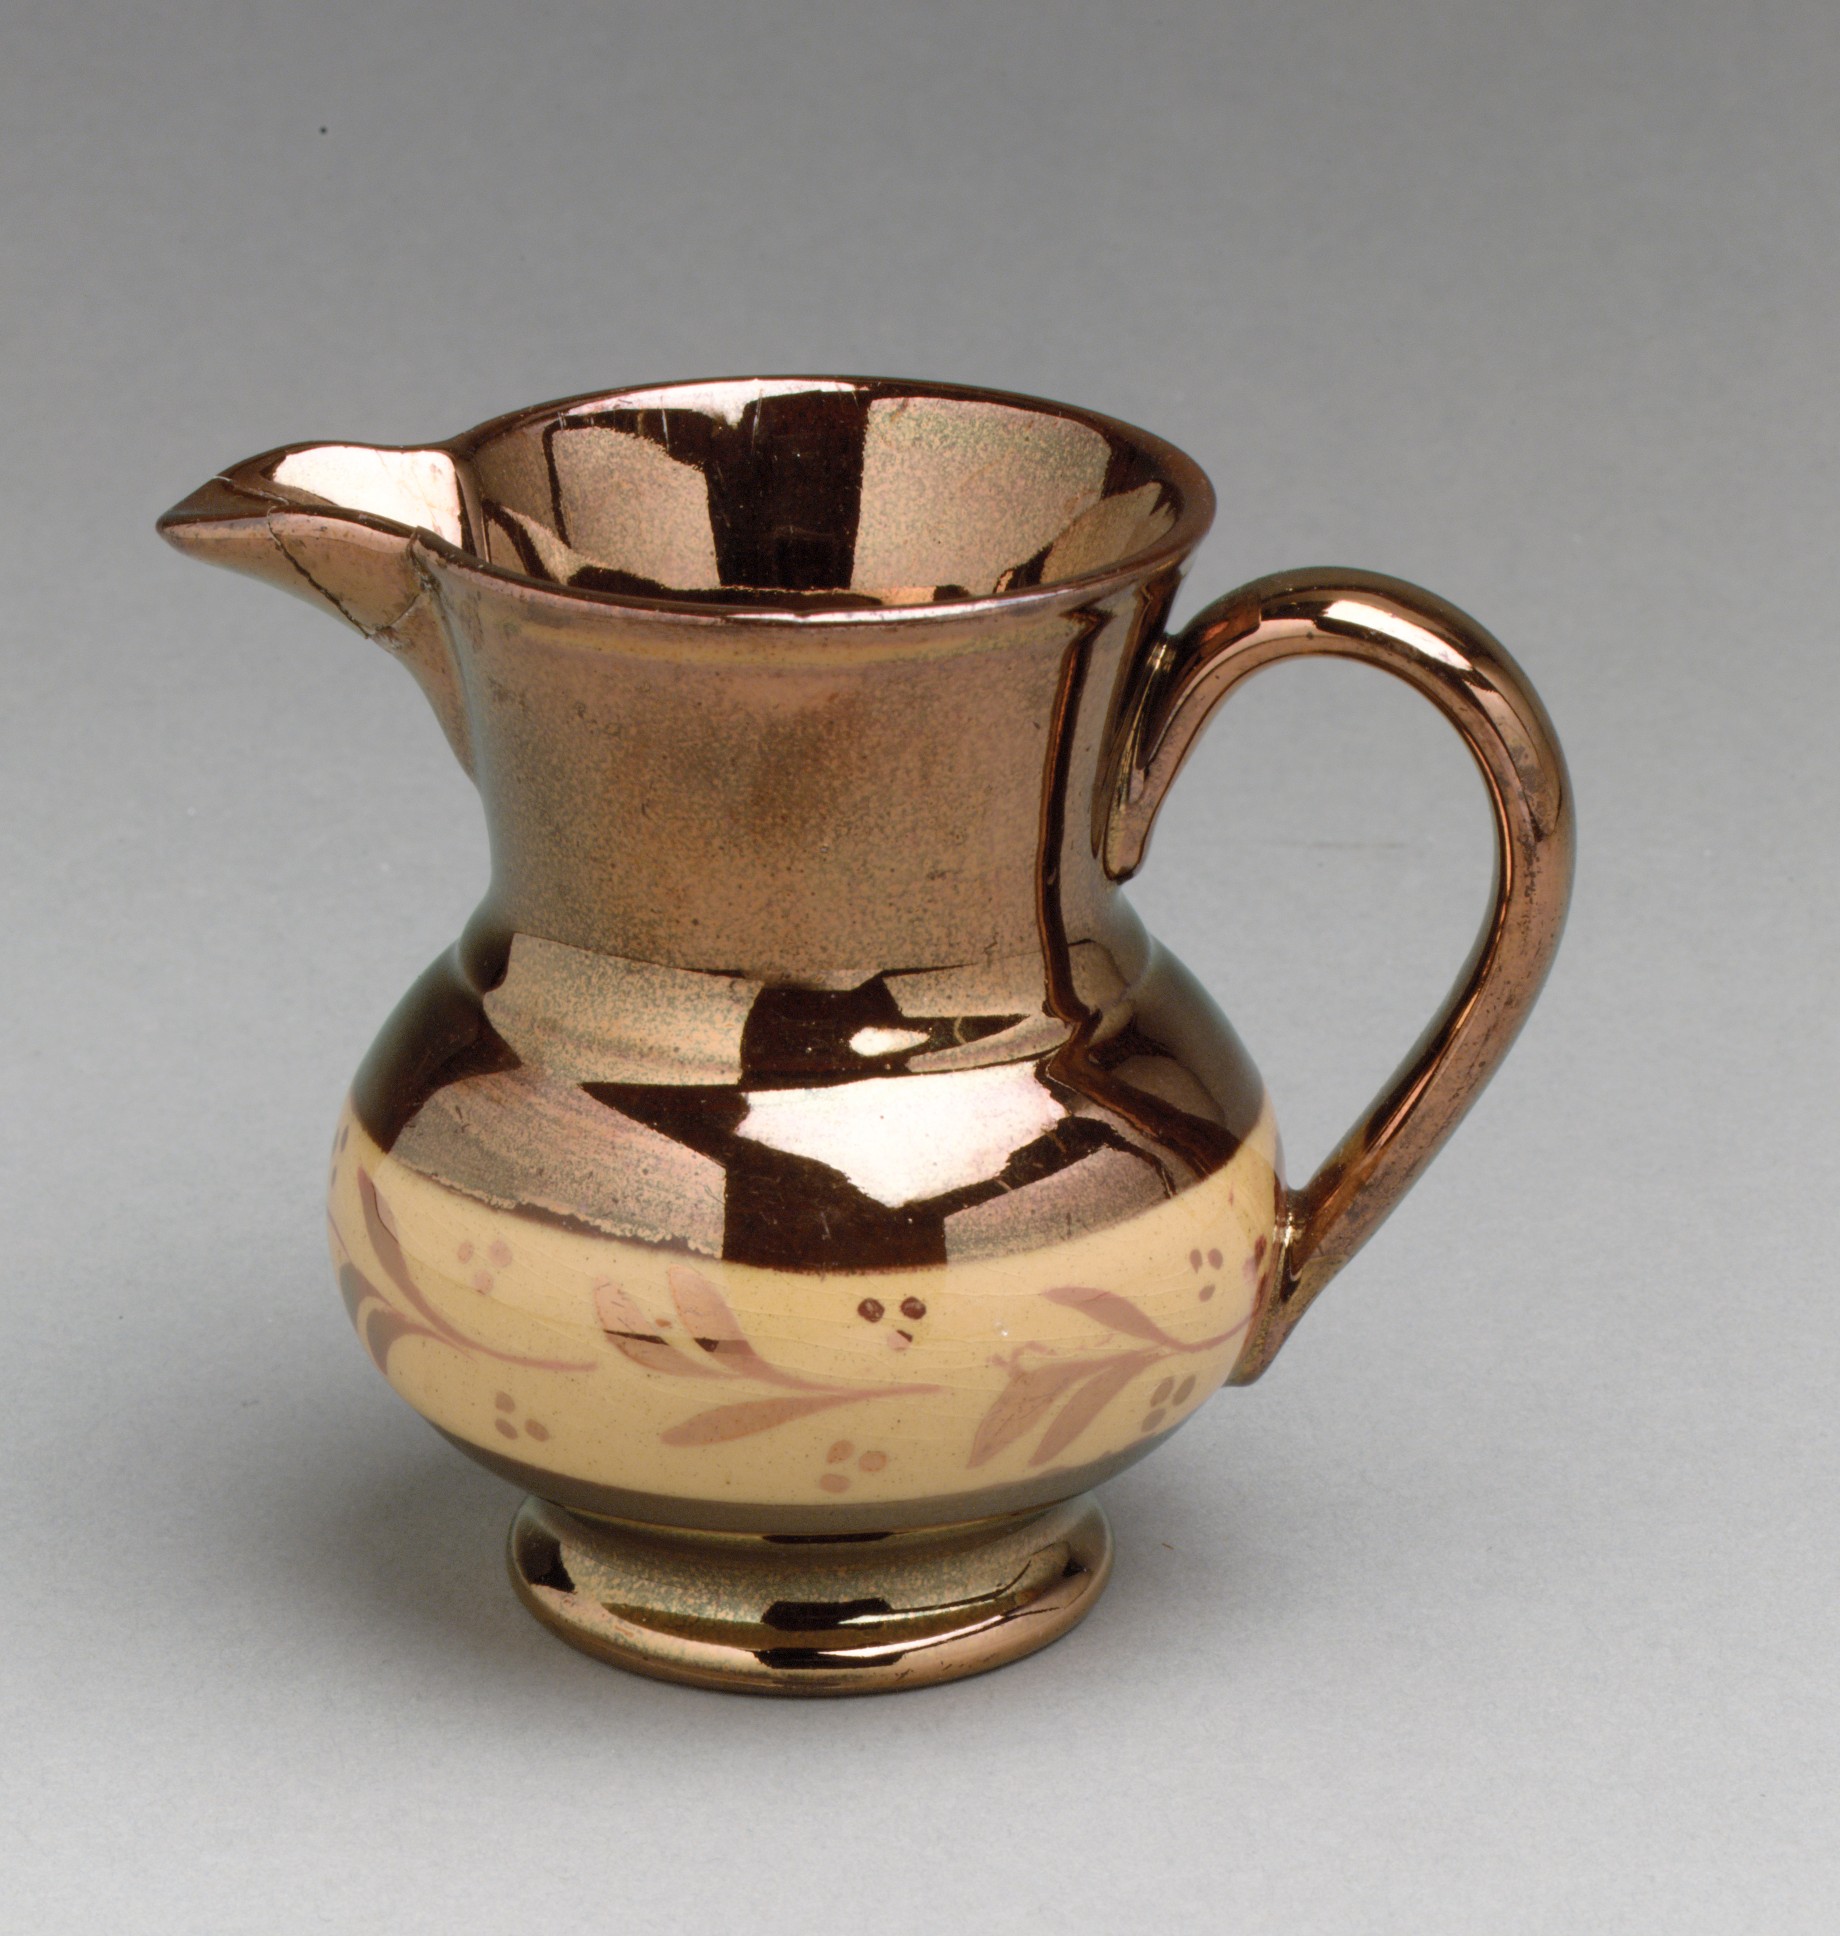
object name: pitcher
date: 1801-1900